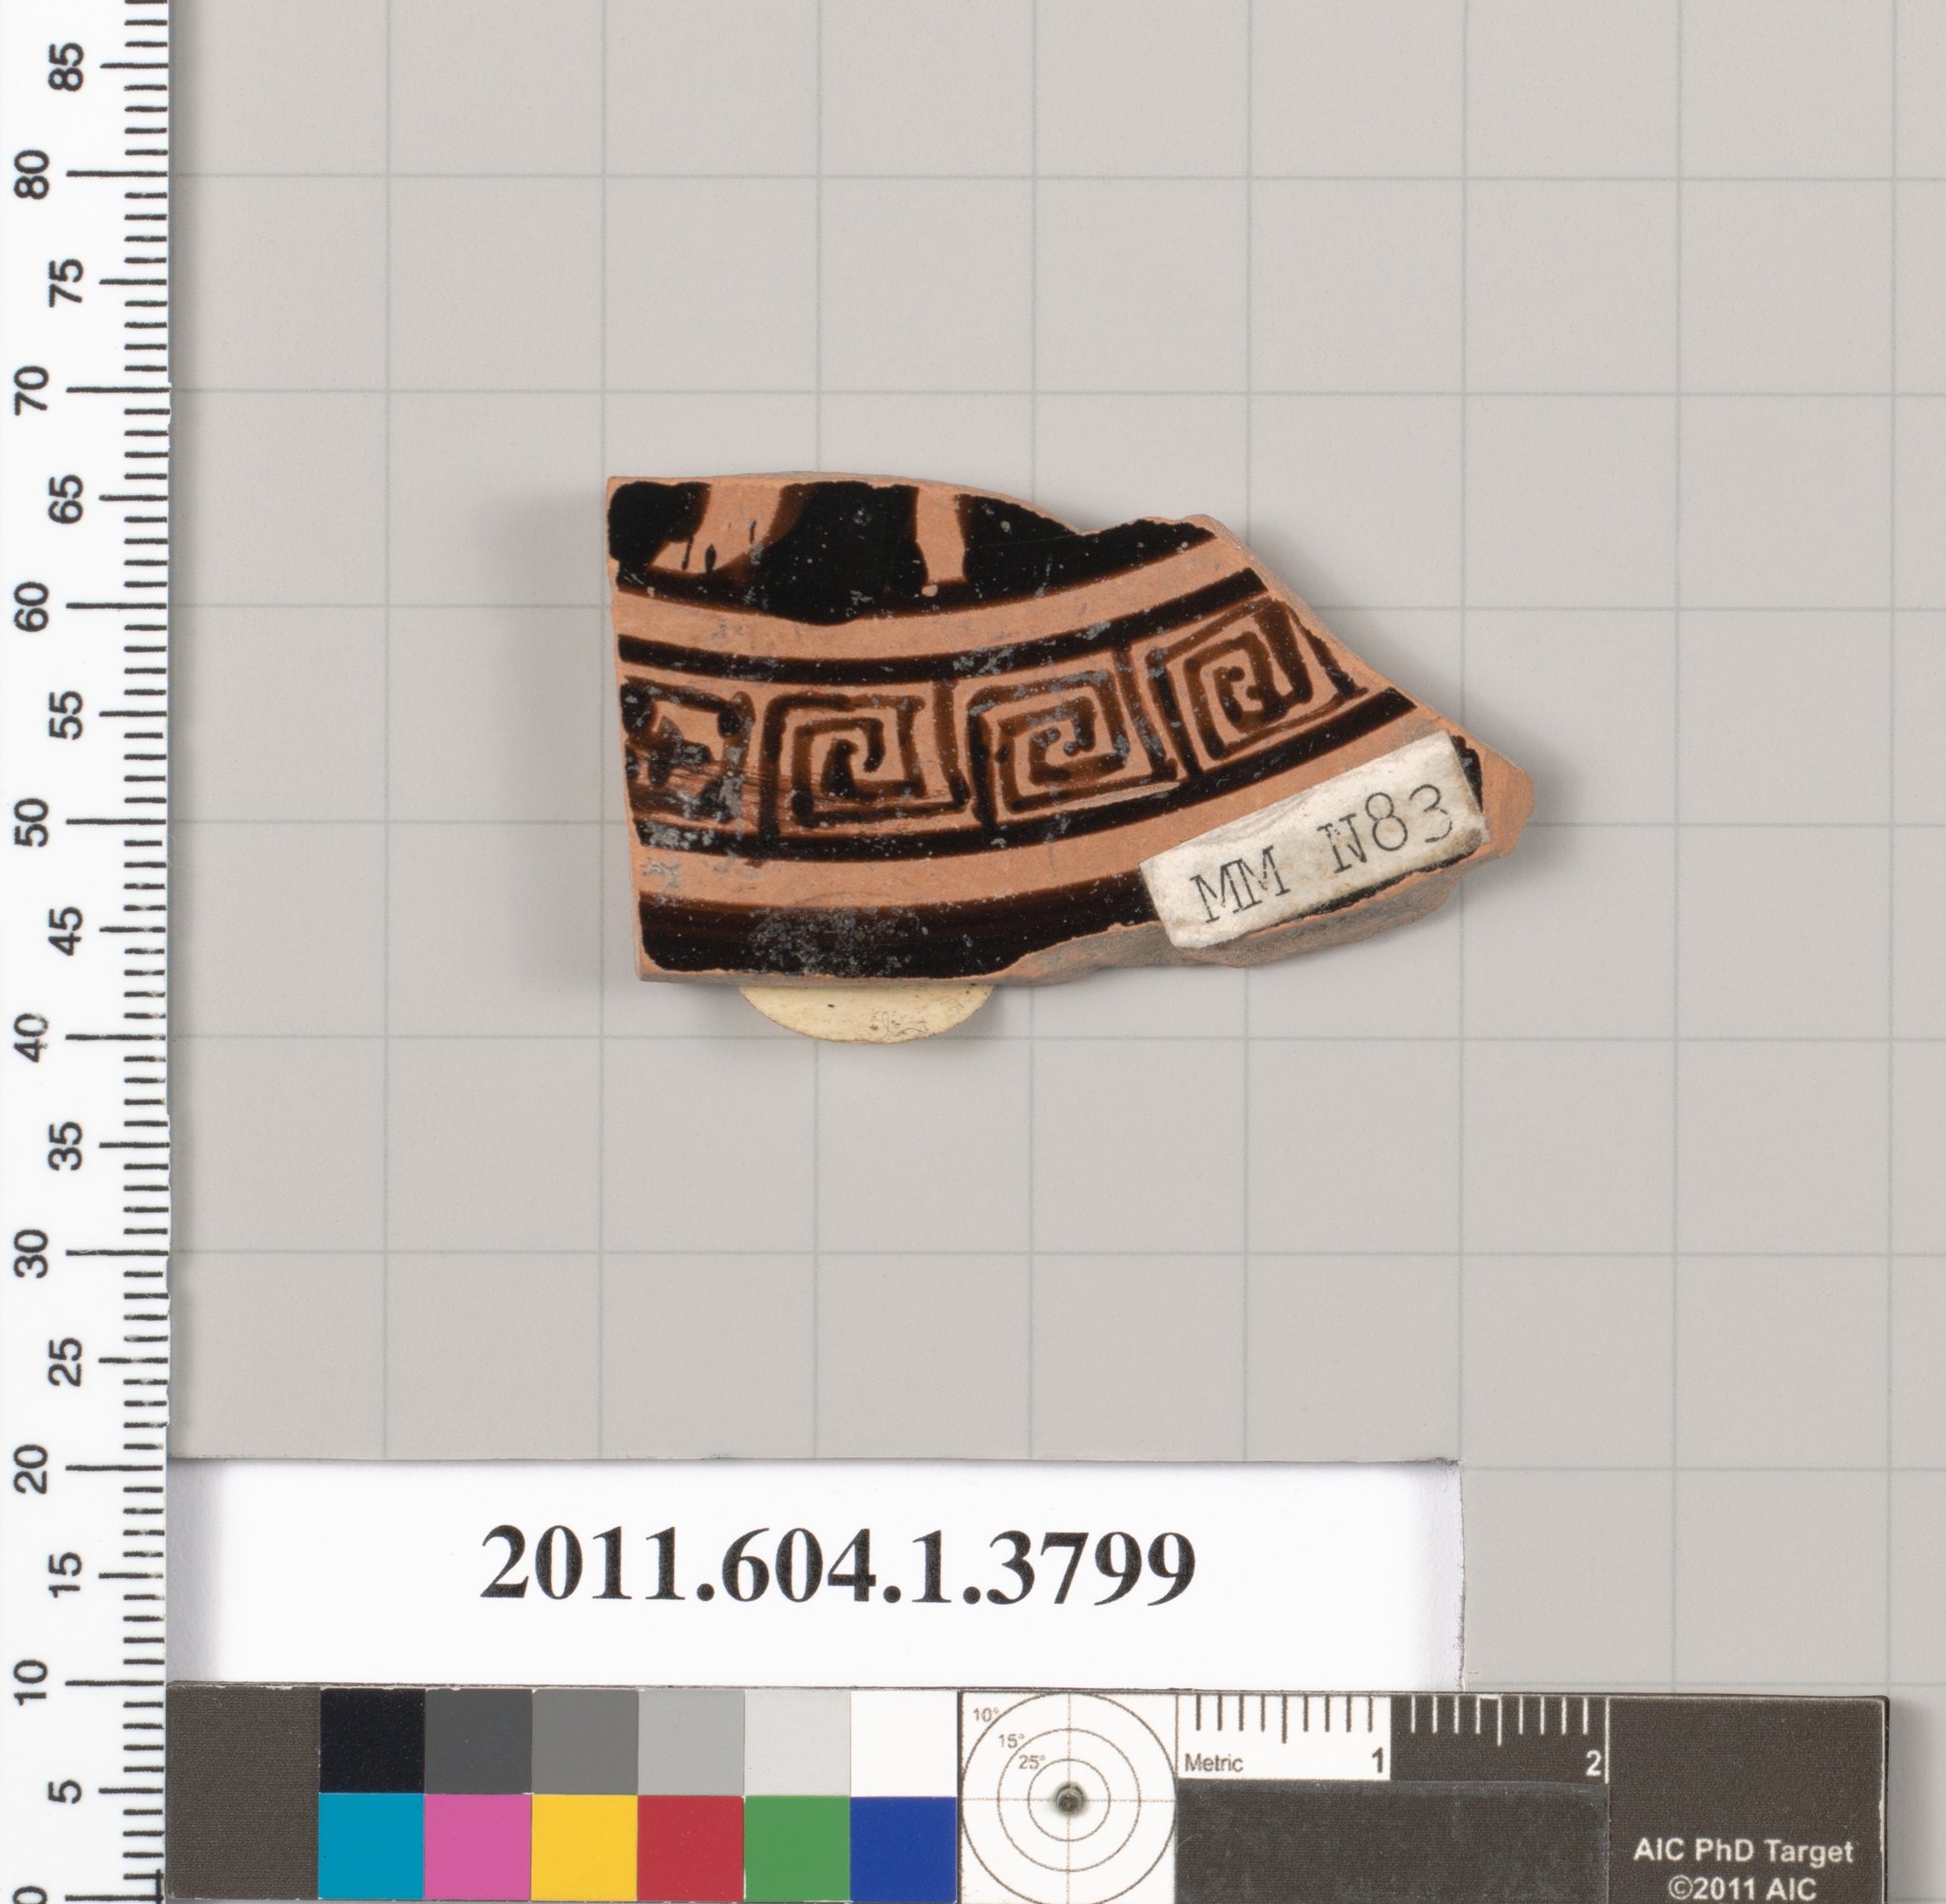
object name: kylix fragment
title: Terracotta fragment of a kylix (drinking cup)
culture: greek, attic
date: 460-450 BCE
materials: terracotta